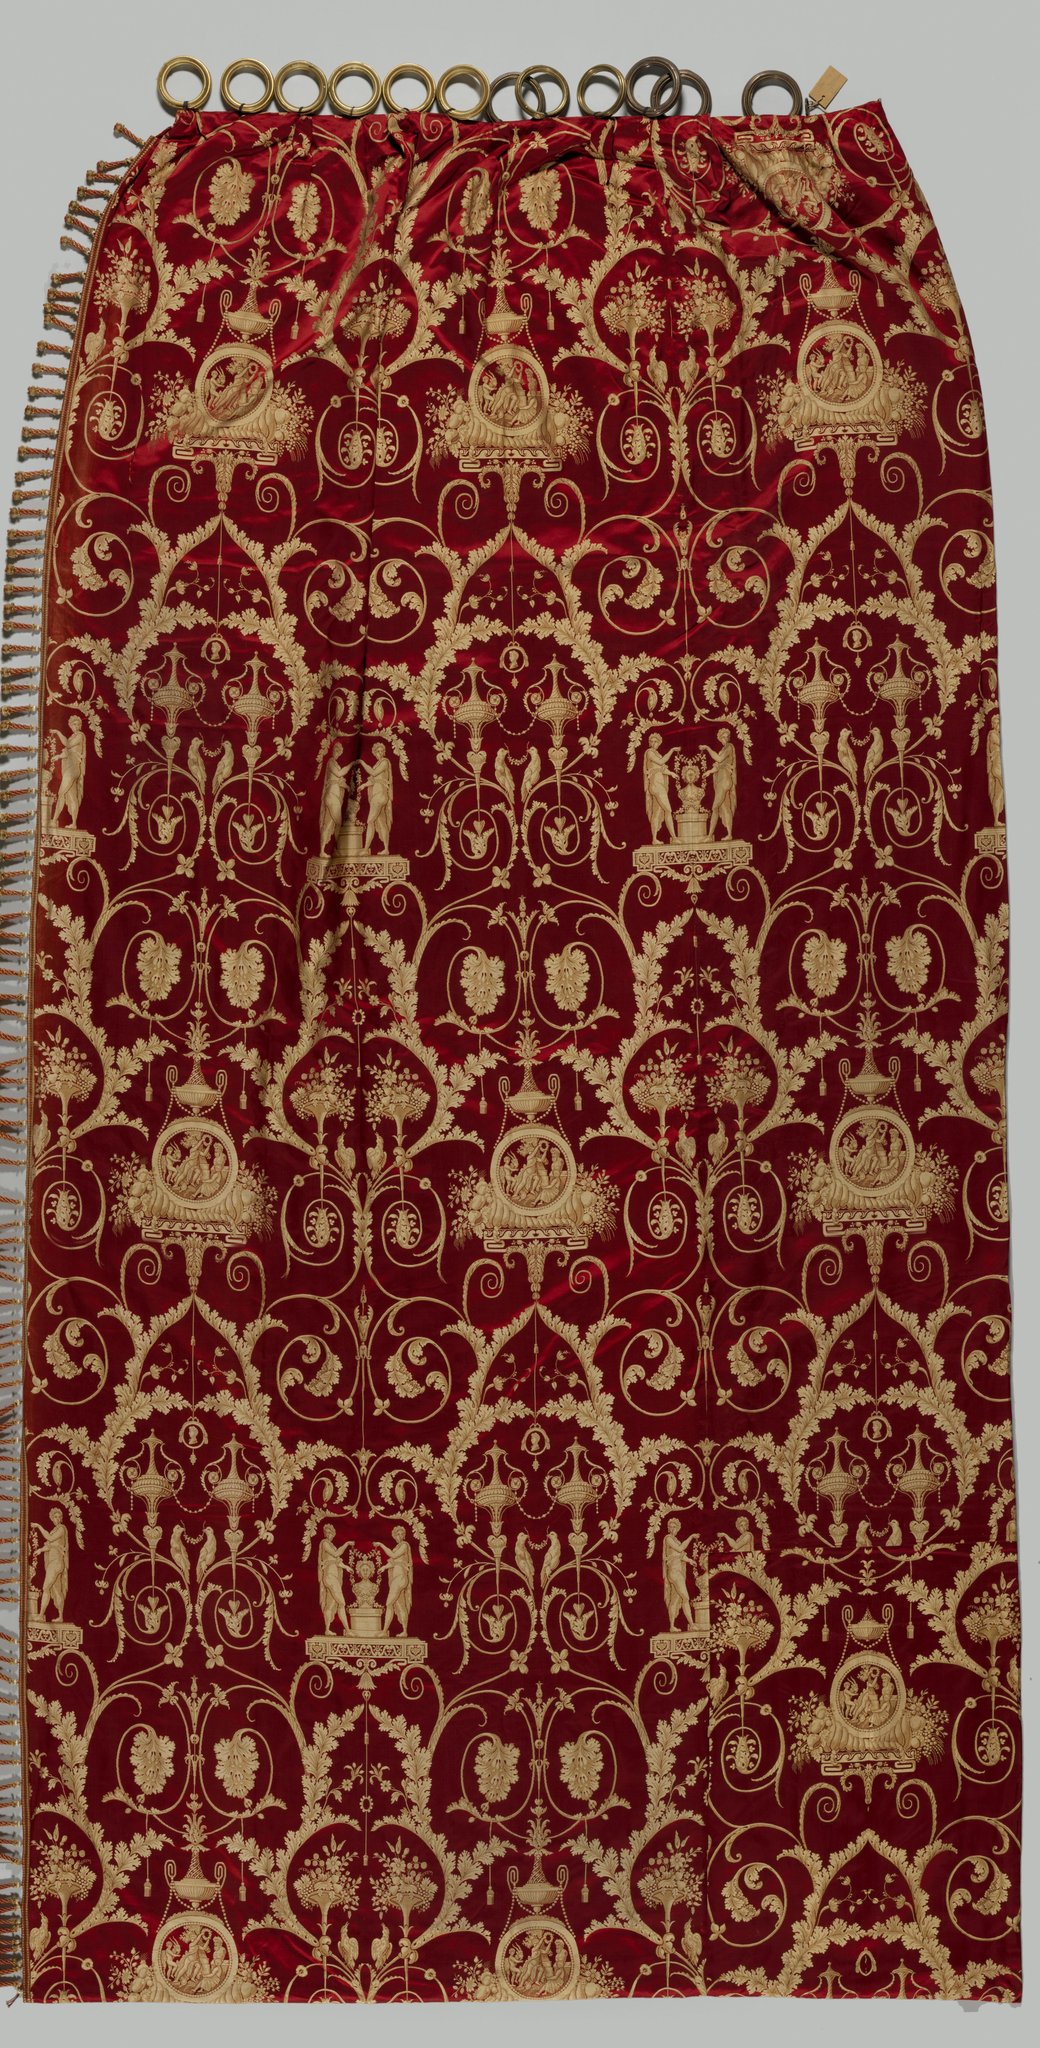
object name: curtain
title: Gordijn met imitatiestijl Directoire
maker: Anonymous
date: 1800-1825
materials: brass, cotton, textile, silk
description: Gordijn met groteskenpatroon van medaillons, portretbustes, vazen en voluutranken in crème tegen een satijnen ondergrond in donker steenrood. Neo-Pompeiaans. Rode voering. Met grote, geprofileerde ringen en franjes langs één kant.